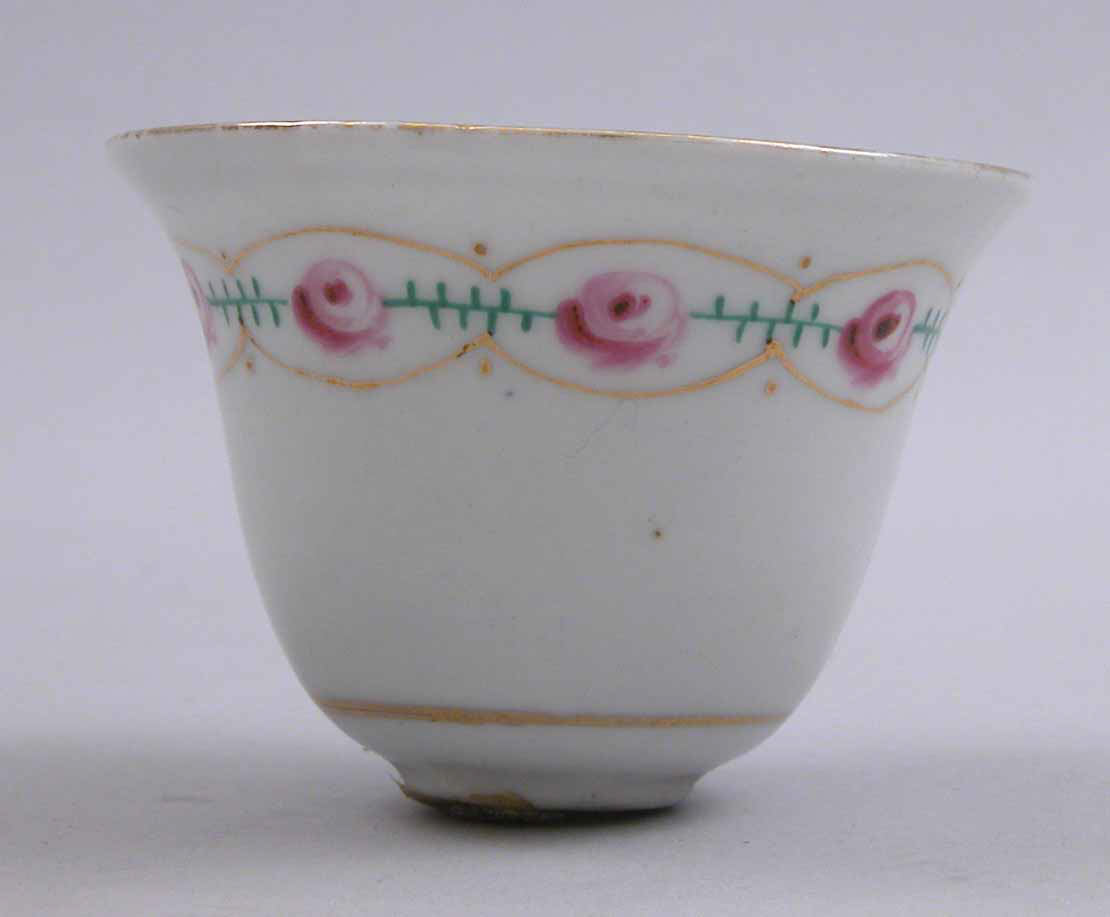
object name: cup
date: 1801-1900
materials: metal, porcelain, silver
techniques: gilding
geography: turkey